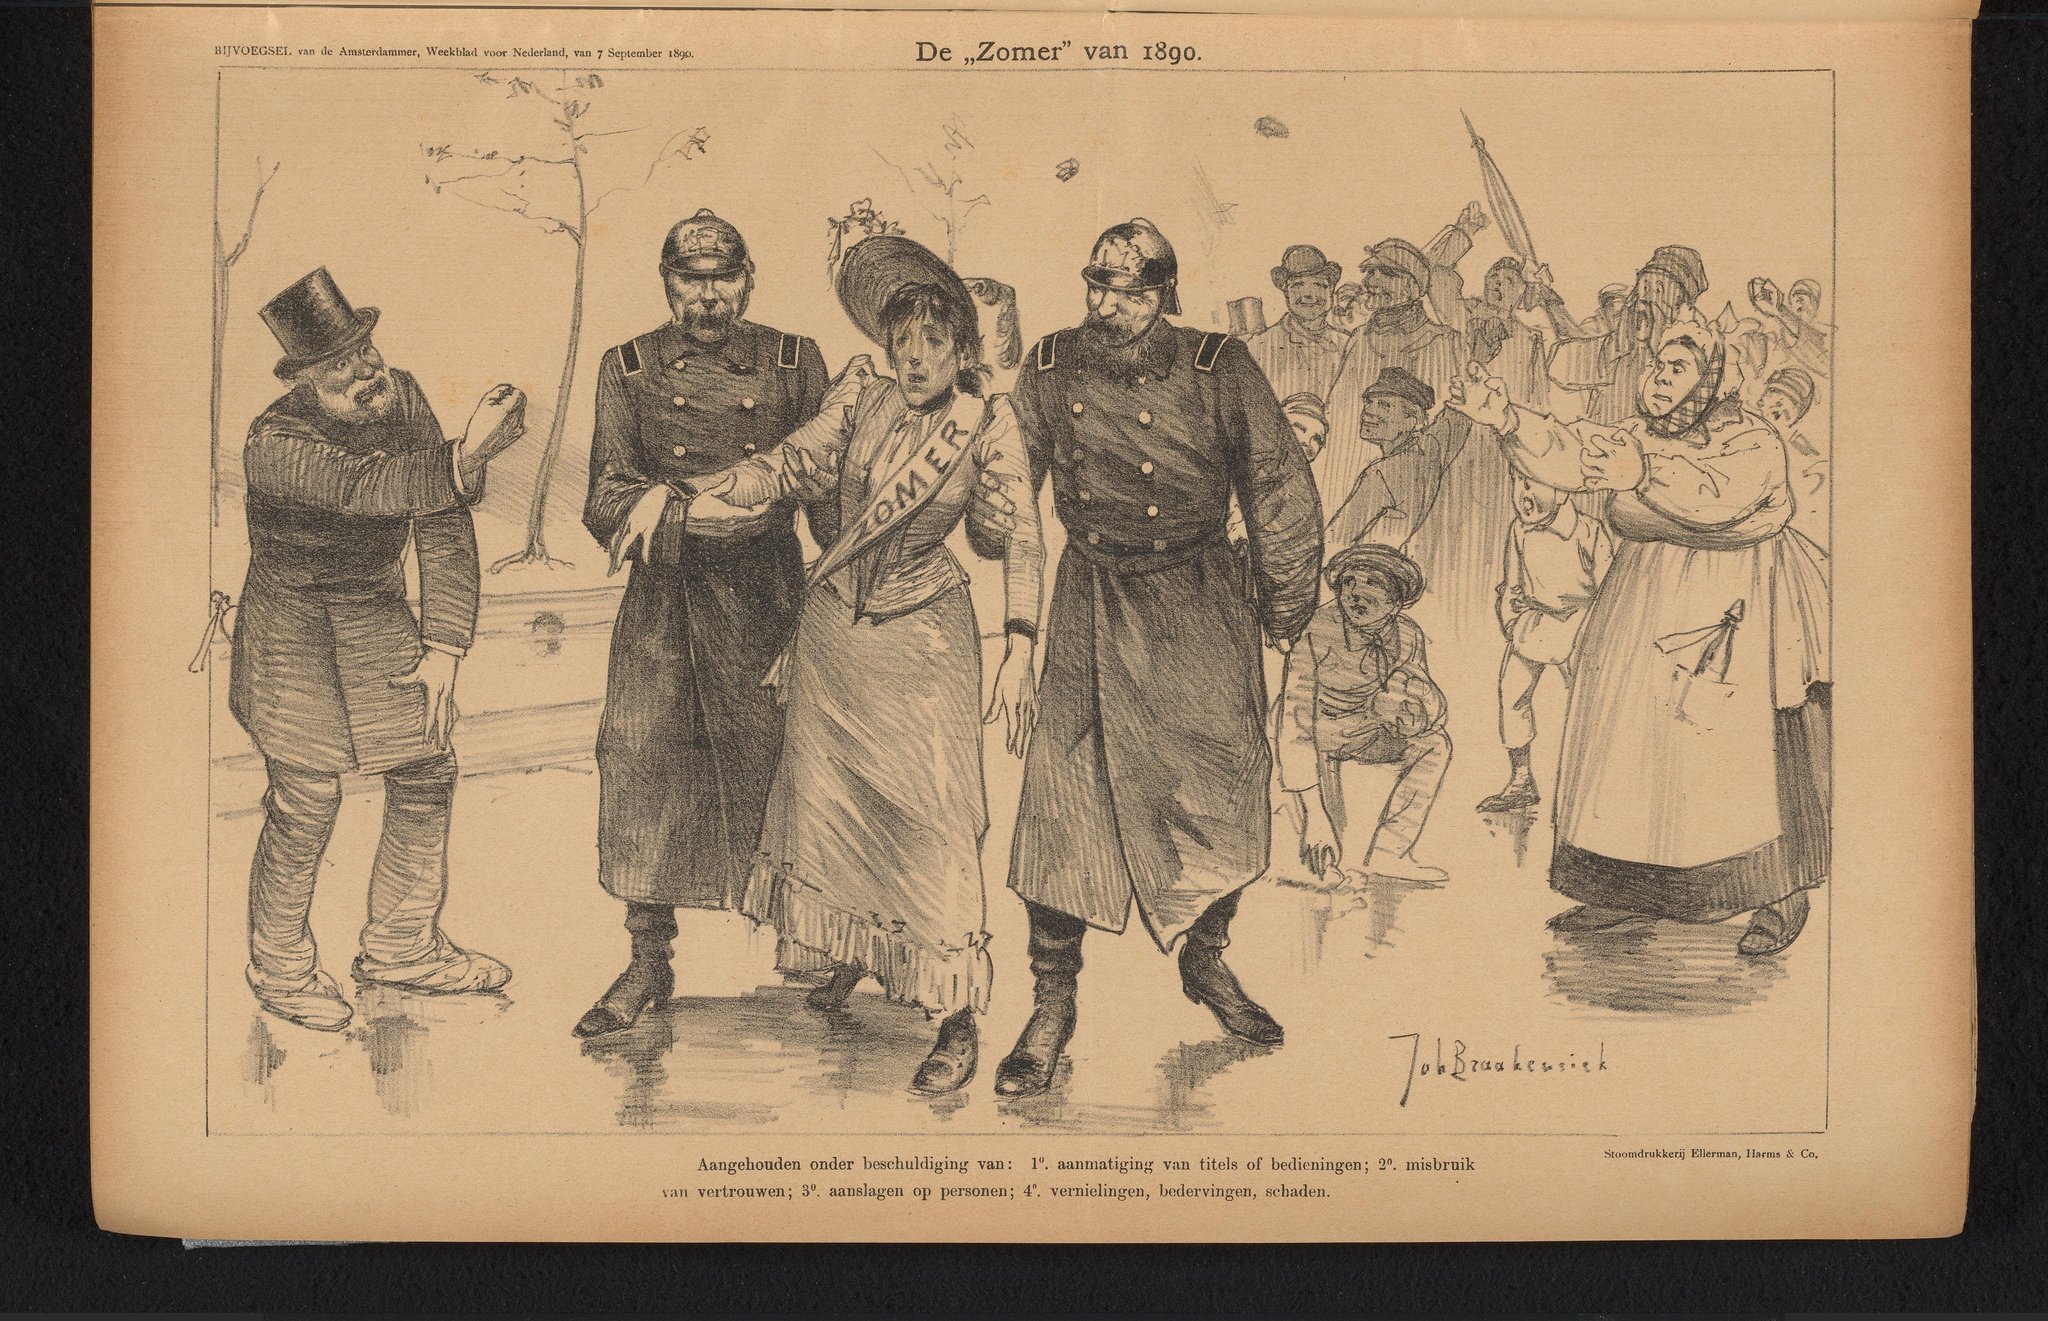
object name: cartoon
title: De "Zomer" van 1890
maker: johan braakensiek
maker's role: draughtsman, print maker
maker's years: 1858-1940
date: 1890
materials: paper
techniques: lithograph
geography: netherlands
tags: summer, 'aestas'; 'estate' (ripa), policeman, constable, street-fights, riots, arrest (of criminal), political caricatures and satires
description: De vrouw 'Zomer' wordt door twee politieagenten aangehouden, boze en ontevreden leden van de bevolking schelden en gooien met stenen. Vanwege de slechte zomer van 1890.